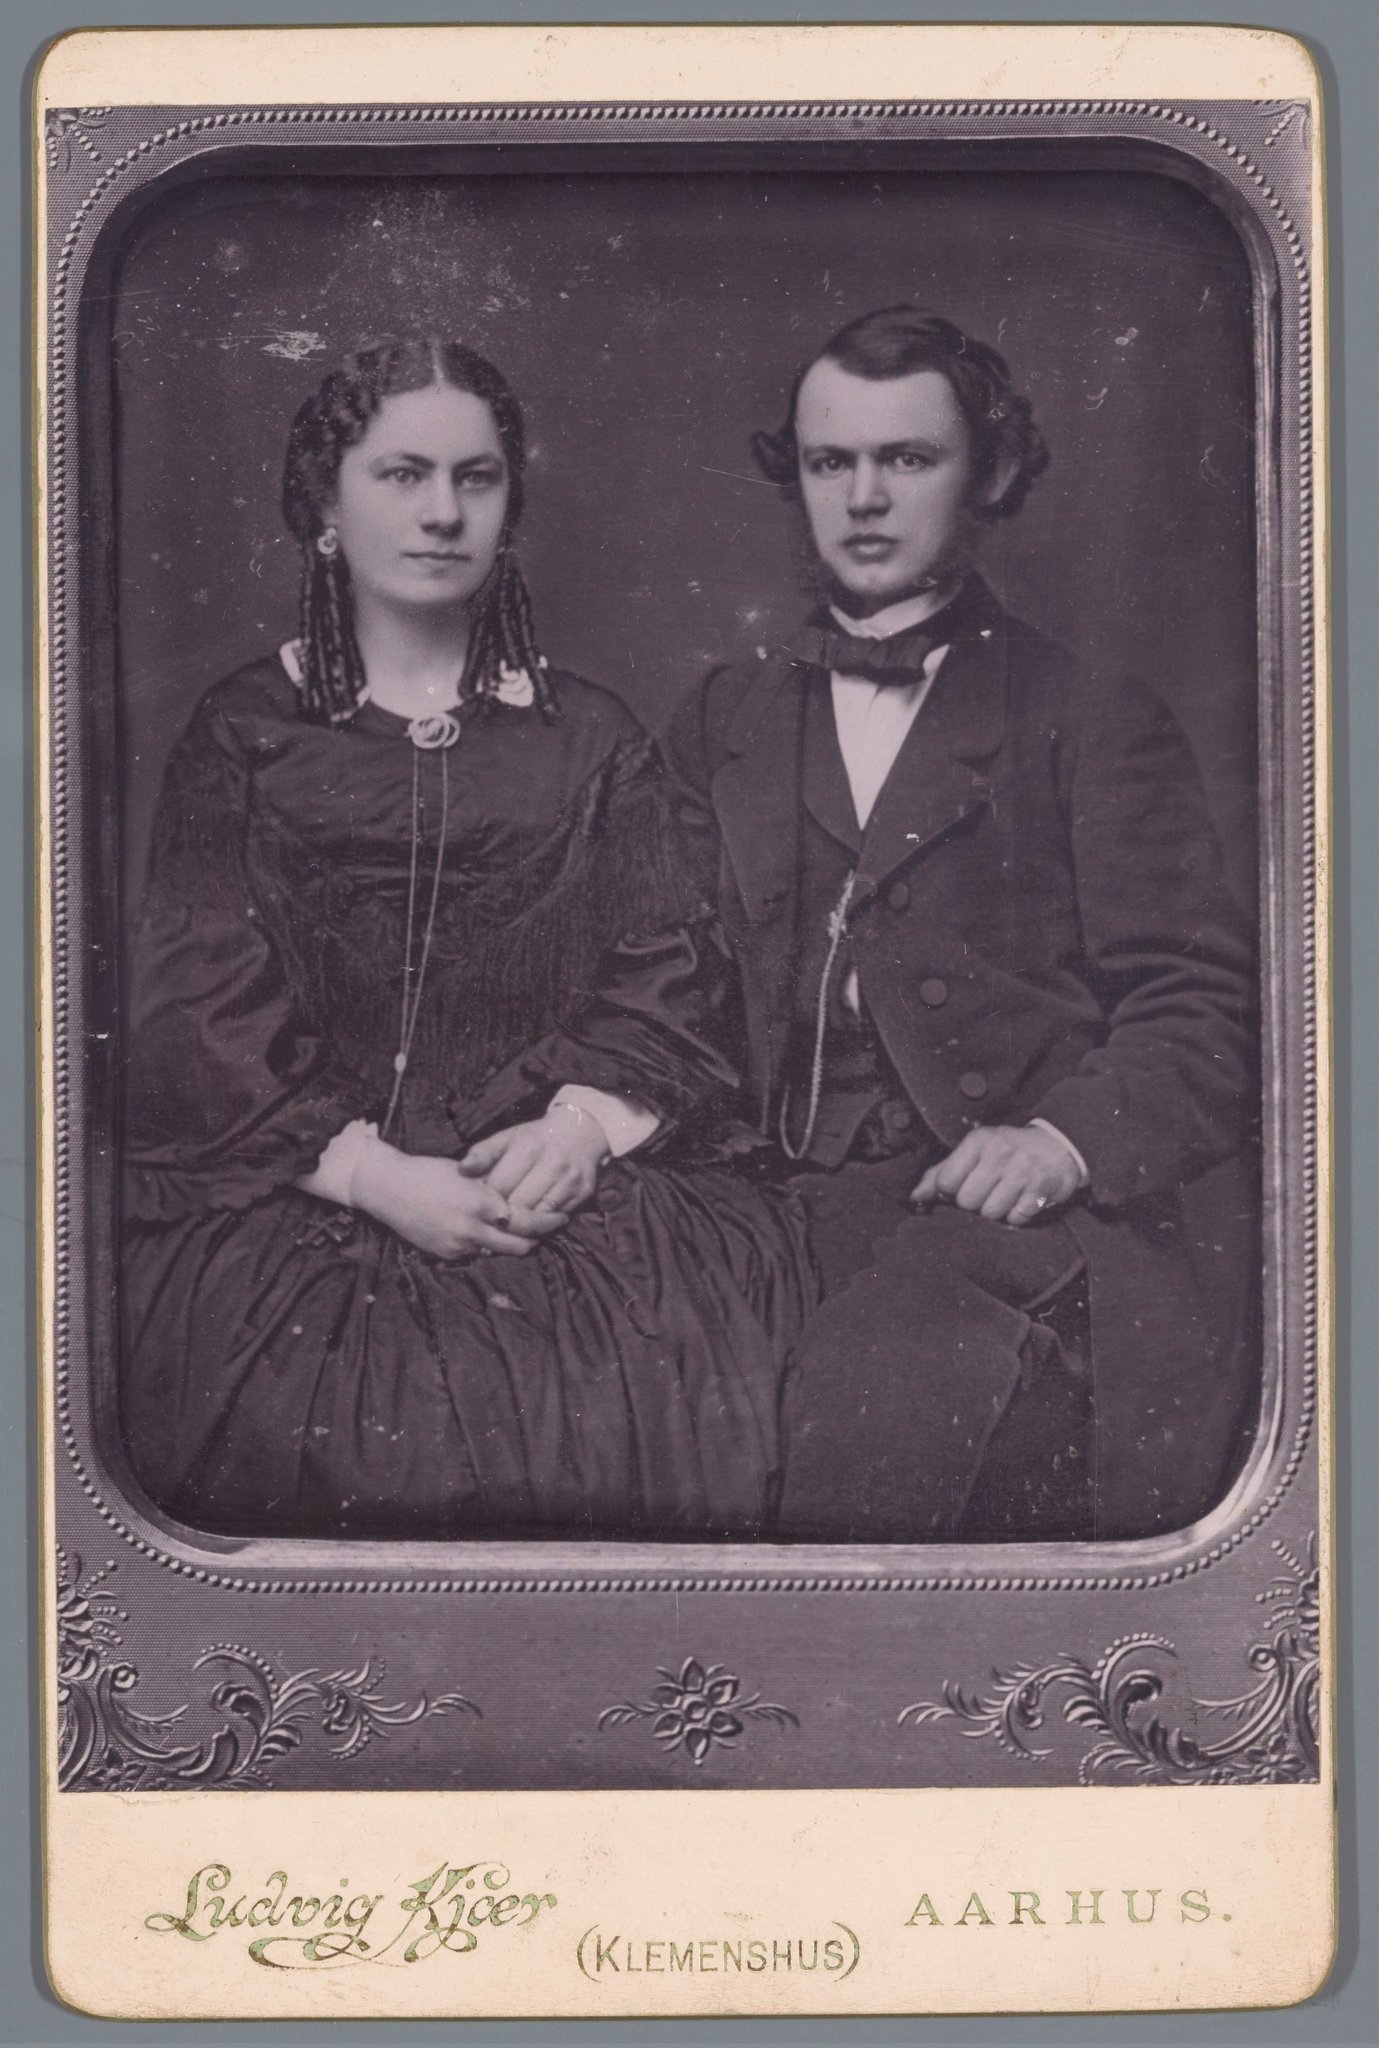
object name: reproduction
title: Fotoreproductie van (vermoedelijk) een daguerreotypie, voorstellende een dubbelportret van een onbekend echtpaar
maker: ludvig kicer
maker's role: fotograaf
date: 1880-1900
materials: photographic support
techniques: carbon print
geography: aarhus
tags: couple of lovers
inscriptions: inscription: ‘Cb 1385.’